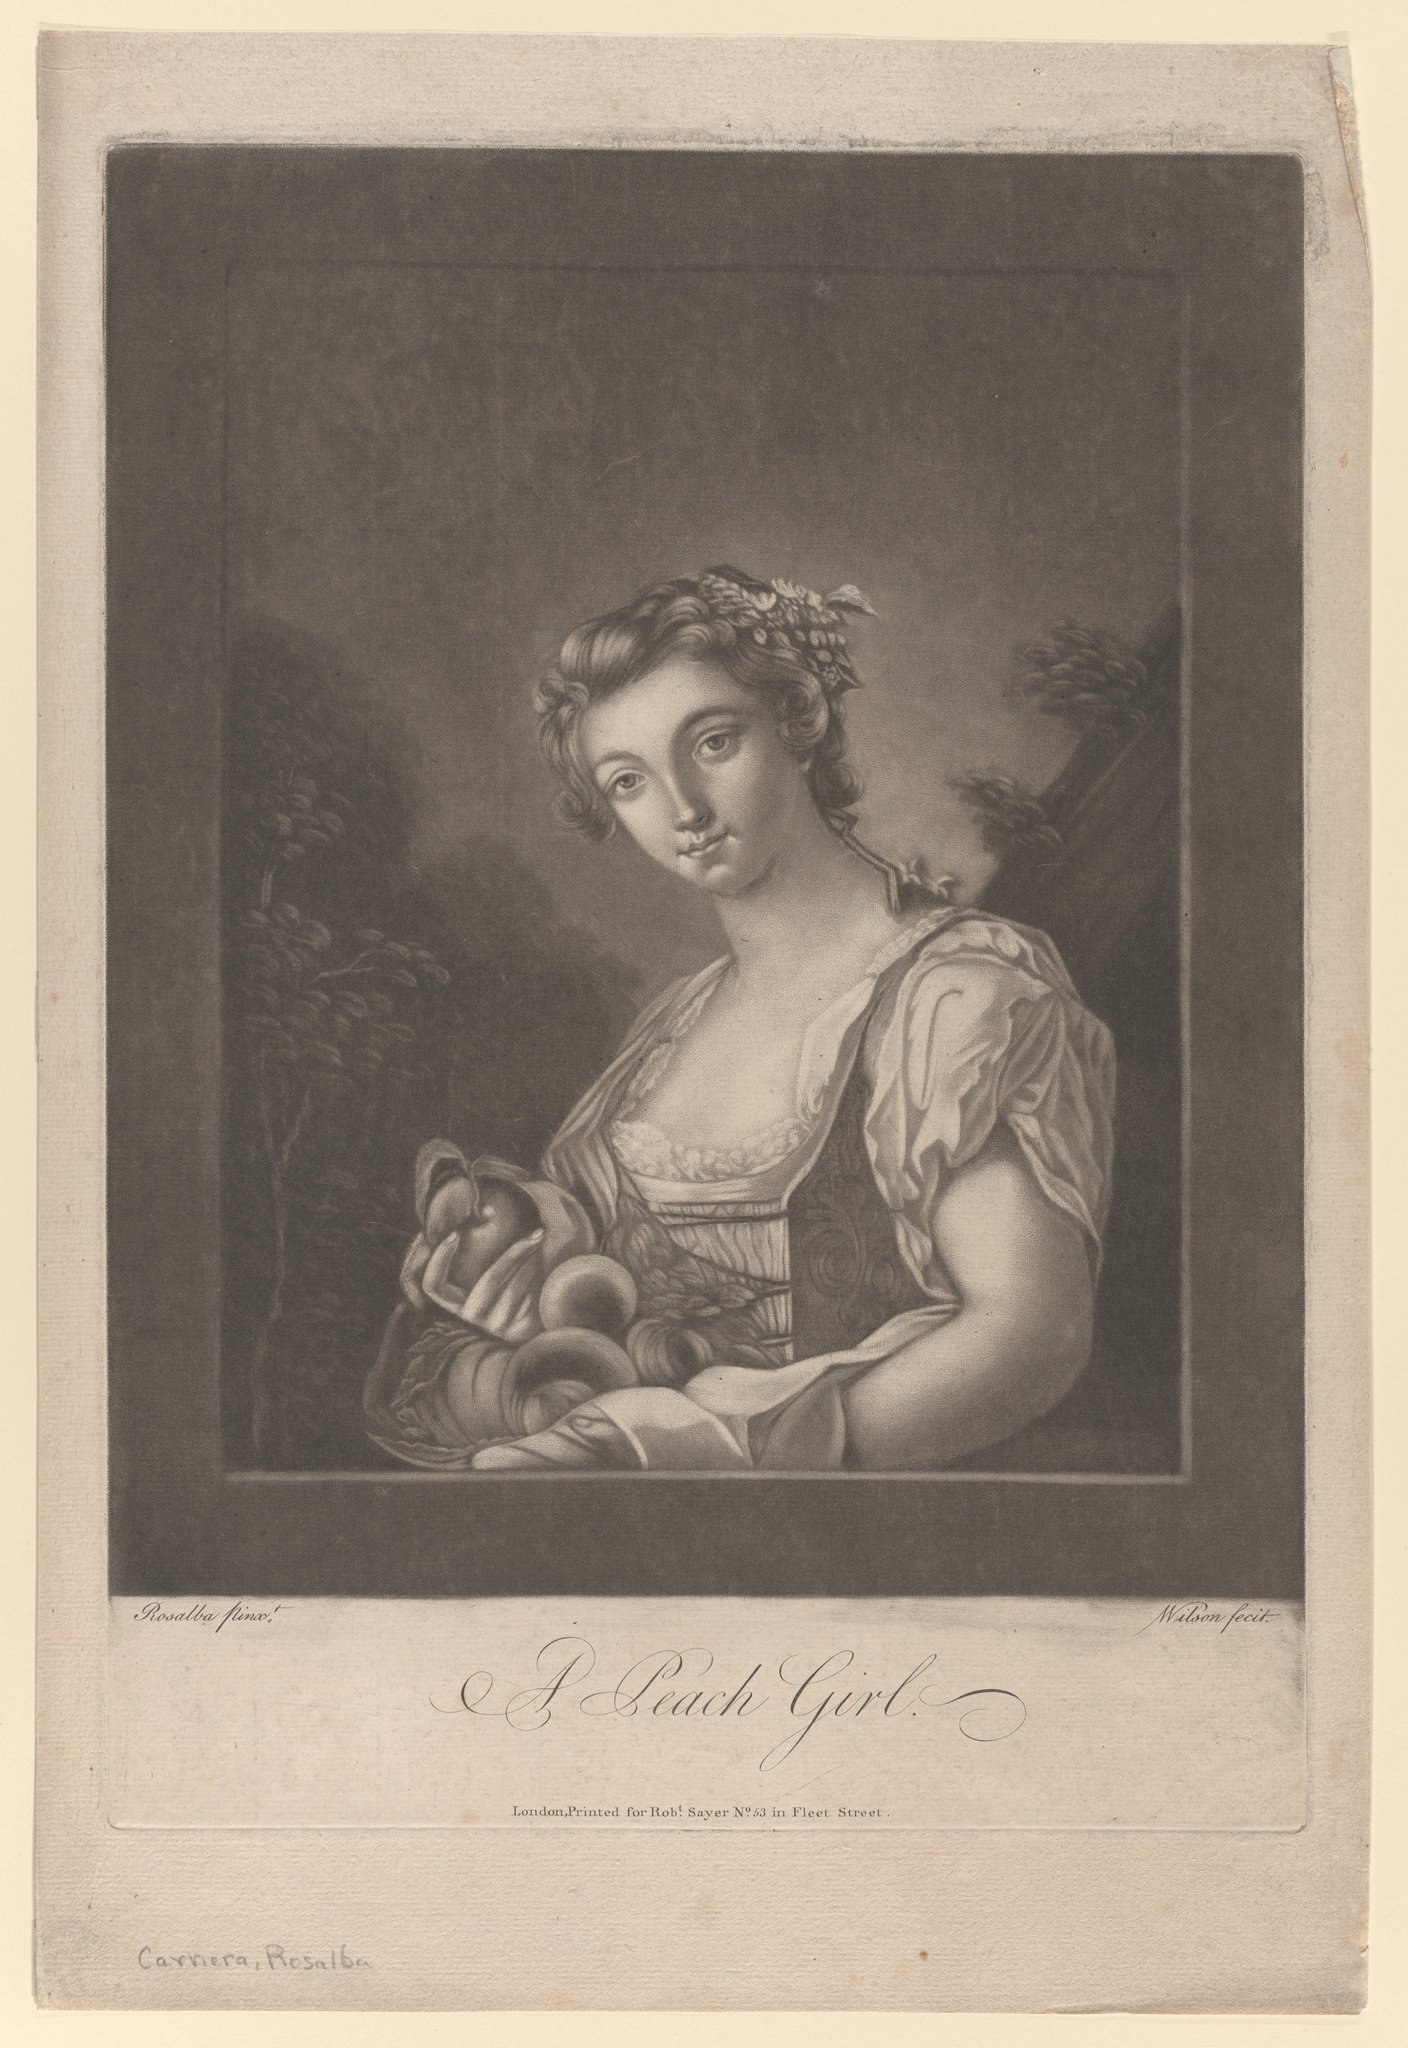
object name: print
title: A Peach Girl: a woman carrying peaches in her apron and holding up one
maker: james wilson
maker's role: artist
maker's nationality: british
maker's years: 1735-1786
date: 1786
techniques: mezzotint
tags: peaches,women